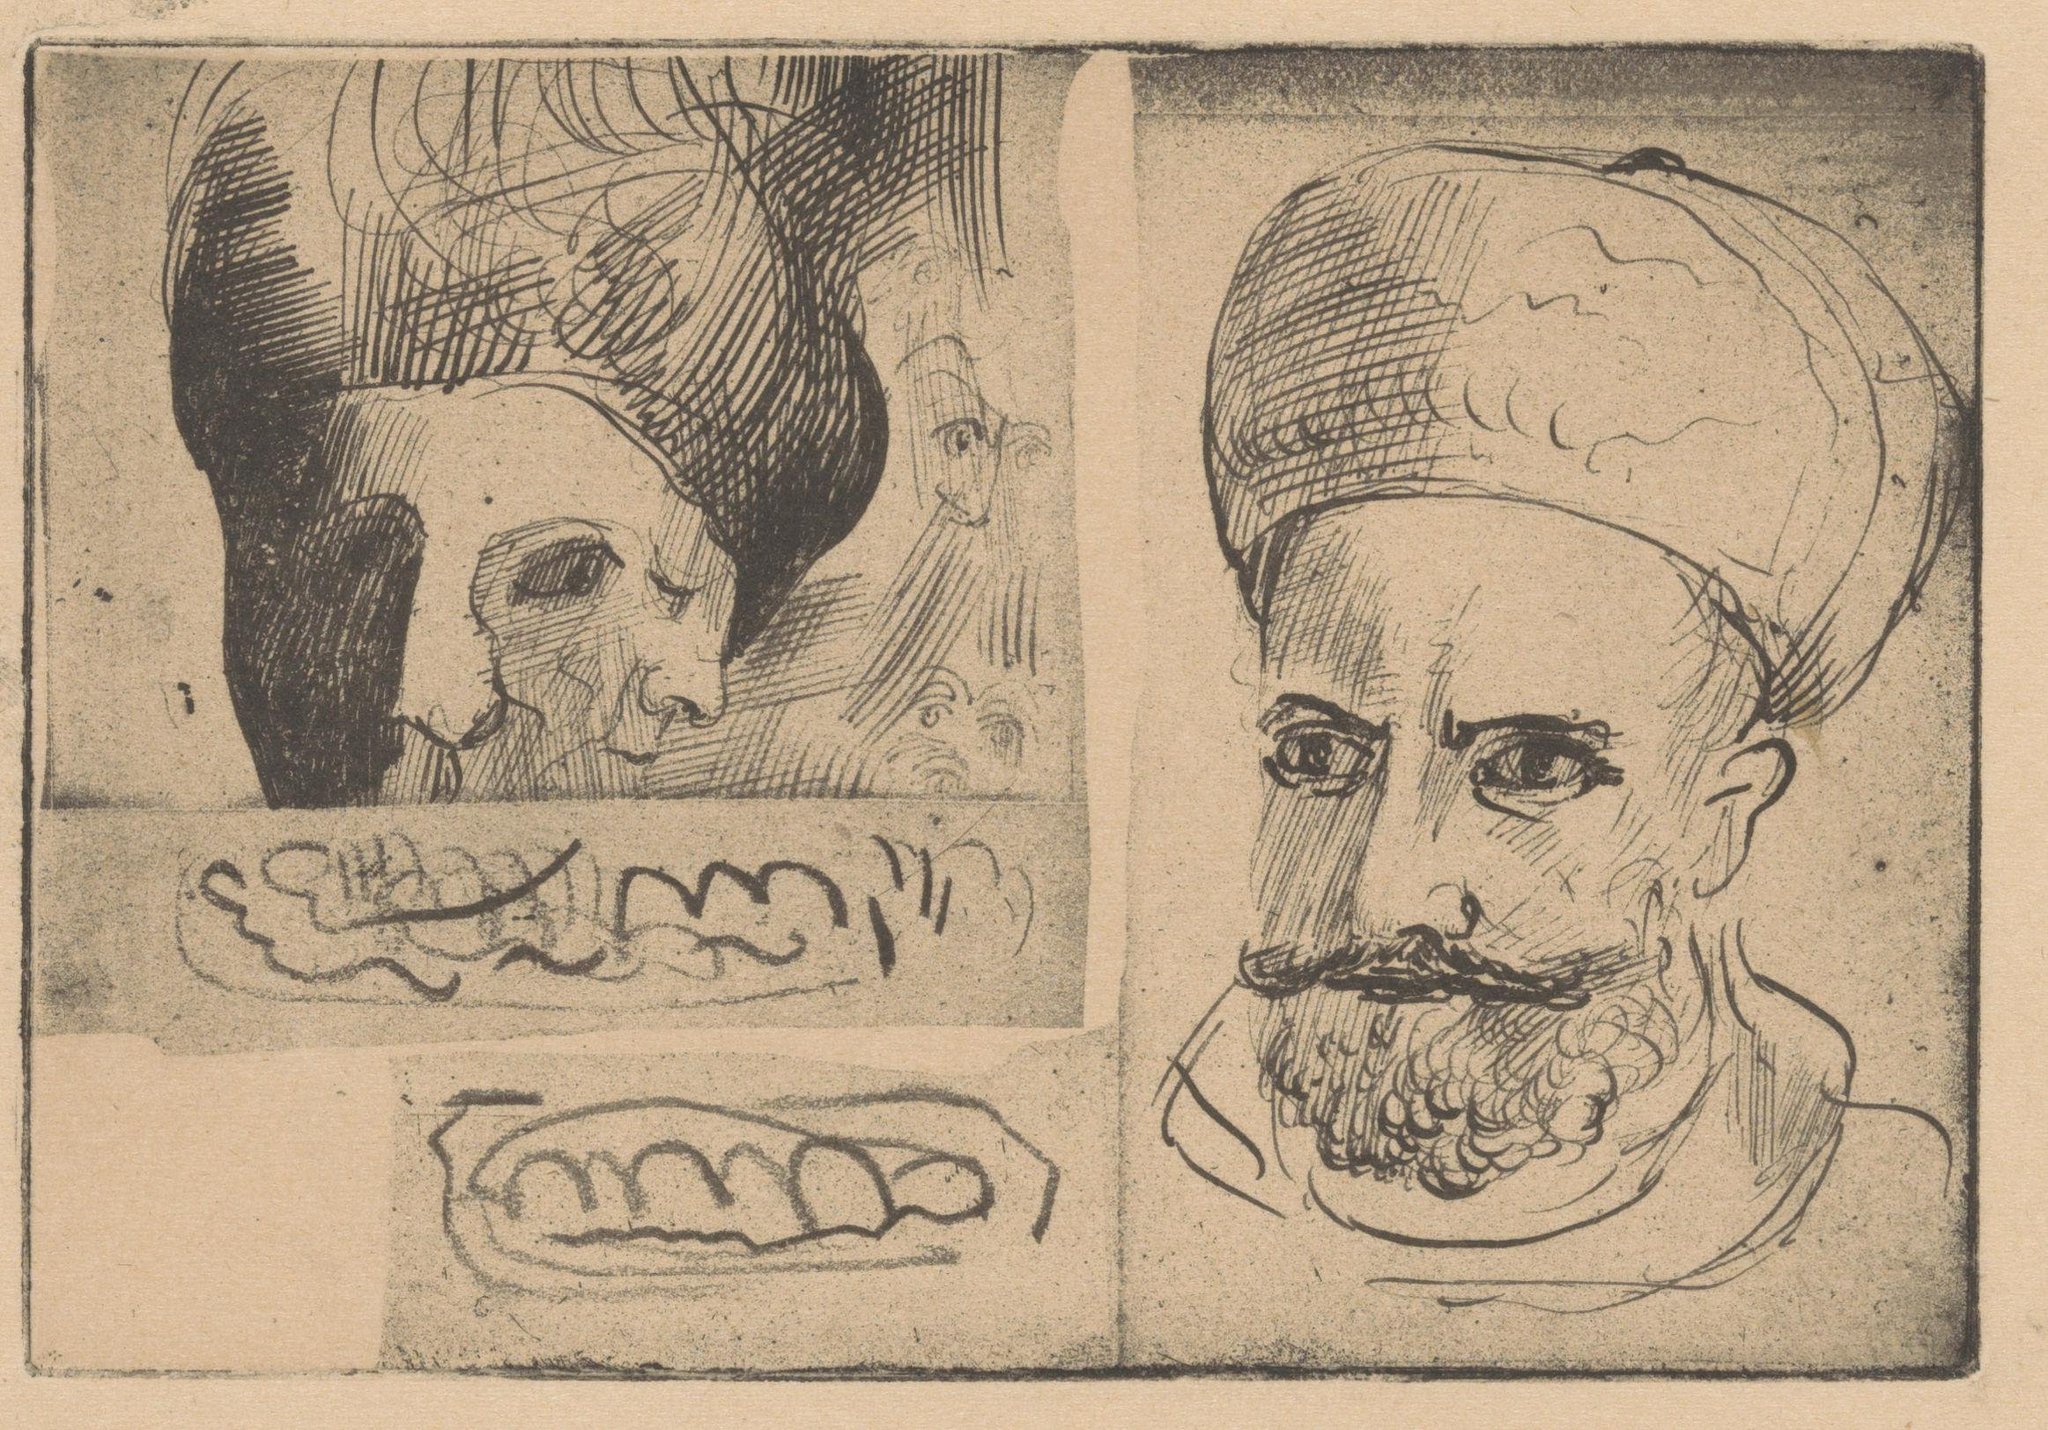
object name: print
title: Studie van drie mannenhoofden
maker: marius holleman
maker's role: draughtsman, print maker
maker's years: 1878-1926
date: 1904-1926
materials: paper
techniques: etching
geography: groningen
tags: head-gear: turban, beard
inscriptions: collector's mark: Lugt 2228